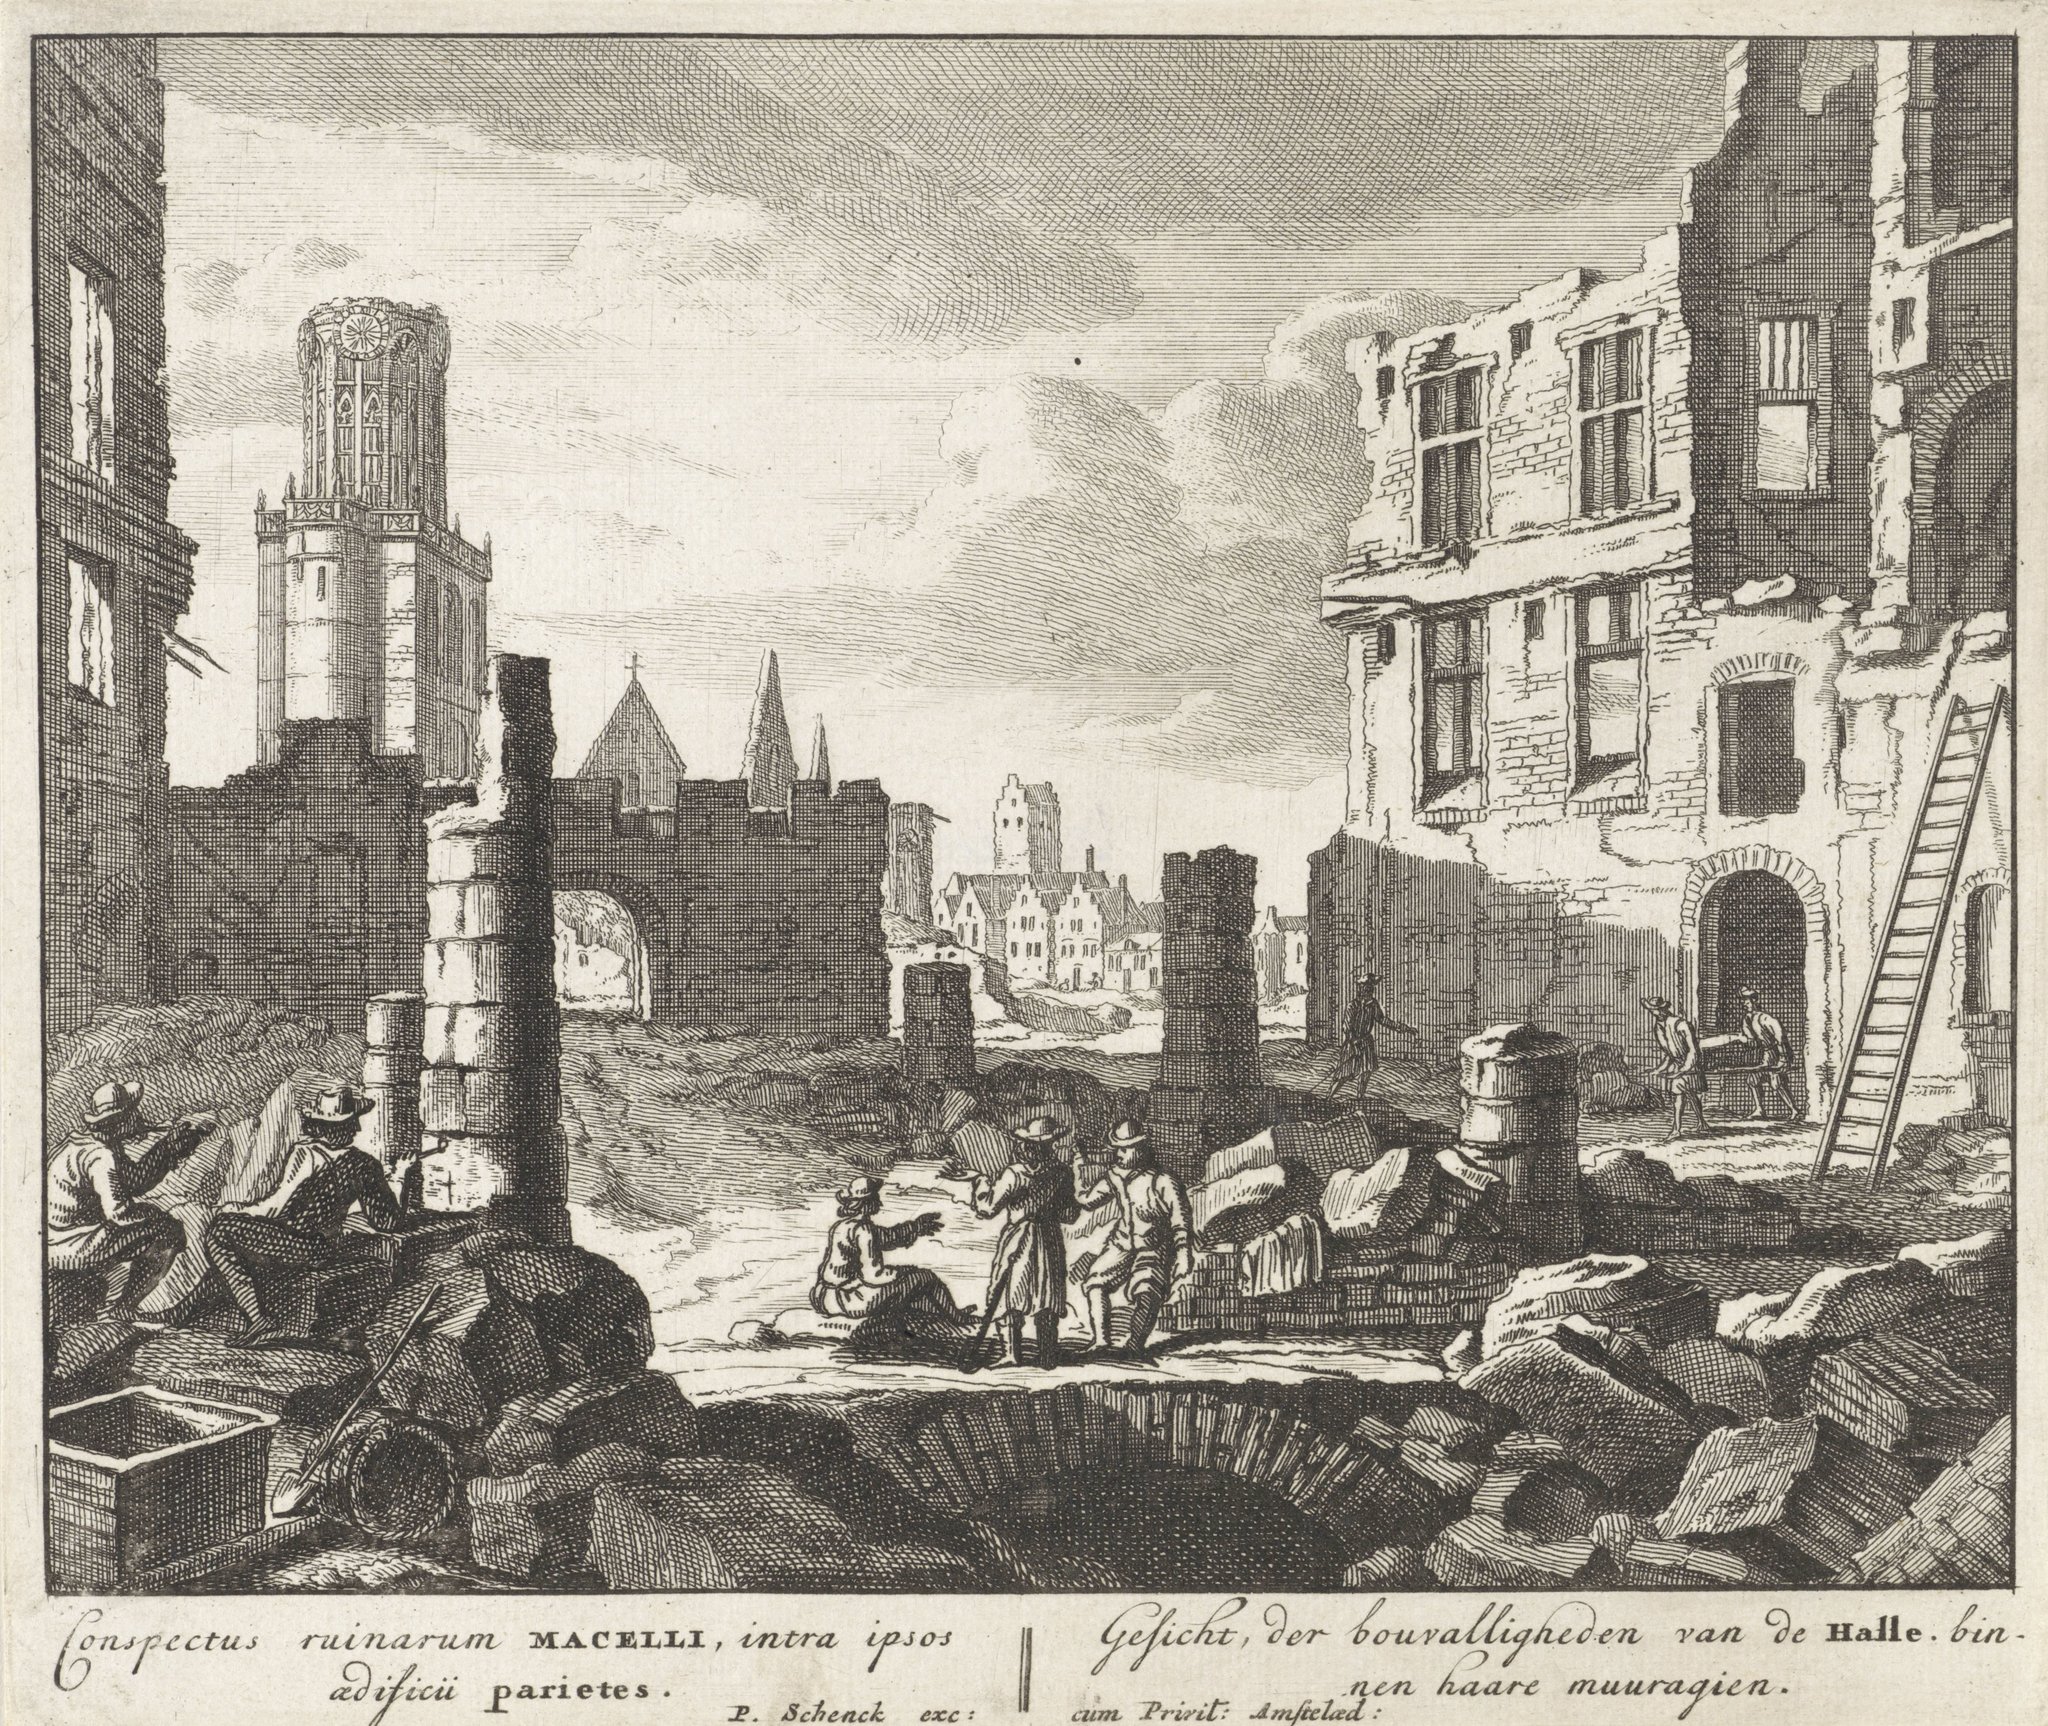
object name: print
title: Ruinae Bruxellenses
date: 1695-1711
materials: paper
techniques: etching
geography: amsterdam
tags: devastated, ruined place or city (~ warfare), brussels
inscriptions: collector's mark: Lugt 2233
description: De ruïnes van de markthal in de Beenhouwersstraat te Brussel na het bombardement door de Fransen, 13-15 augustus 1695.